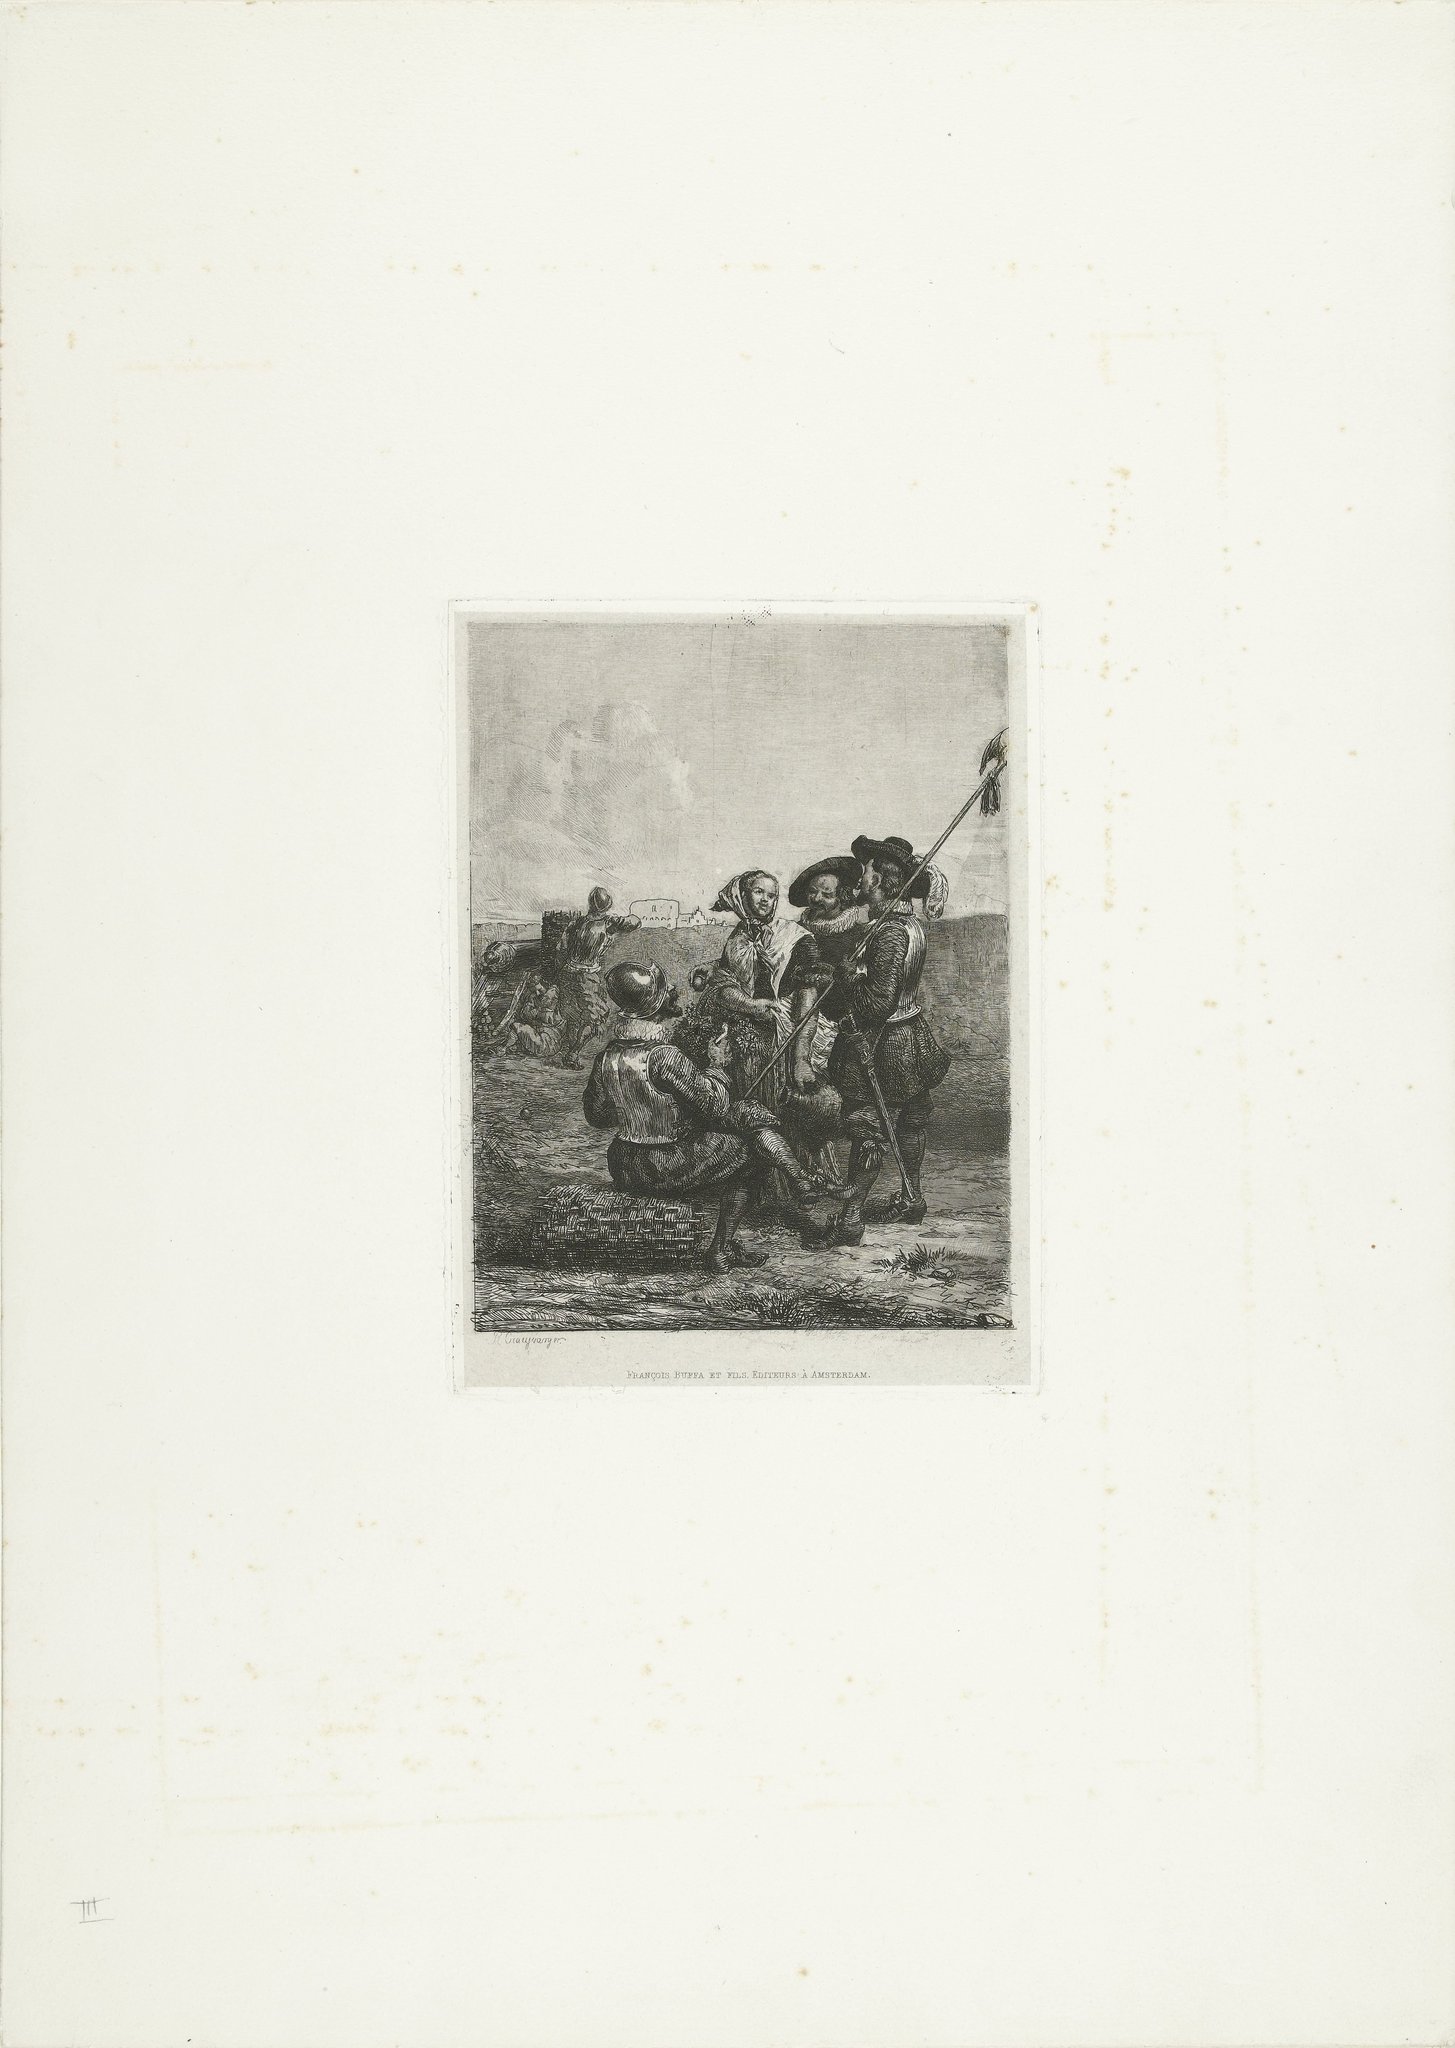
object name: print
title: Soldaten met een jong meisje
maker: reinier craeyvanger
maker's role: draughtsman, print maker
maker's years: 1812-1880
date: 1822-1880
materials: paper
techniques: etching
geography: amsterdam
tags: fortifications, military engineering, firearms: cannon, the soldier; the soldier's life, women camp-followers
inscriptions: collector's mark: Lugt 2228, collector's mark: Lugt 2166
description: Bovenop een versterking van een stad wordt een jong meisje omringd door drie soldaten. Een van de soldaten zit op een mand en rookt pijp. Op de achtergrond een kanon.